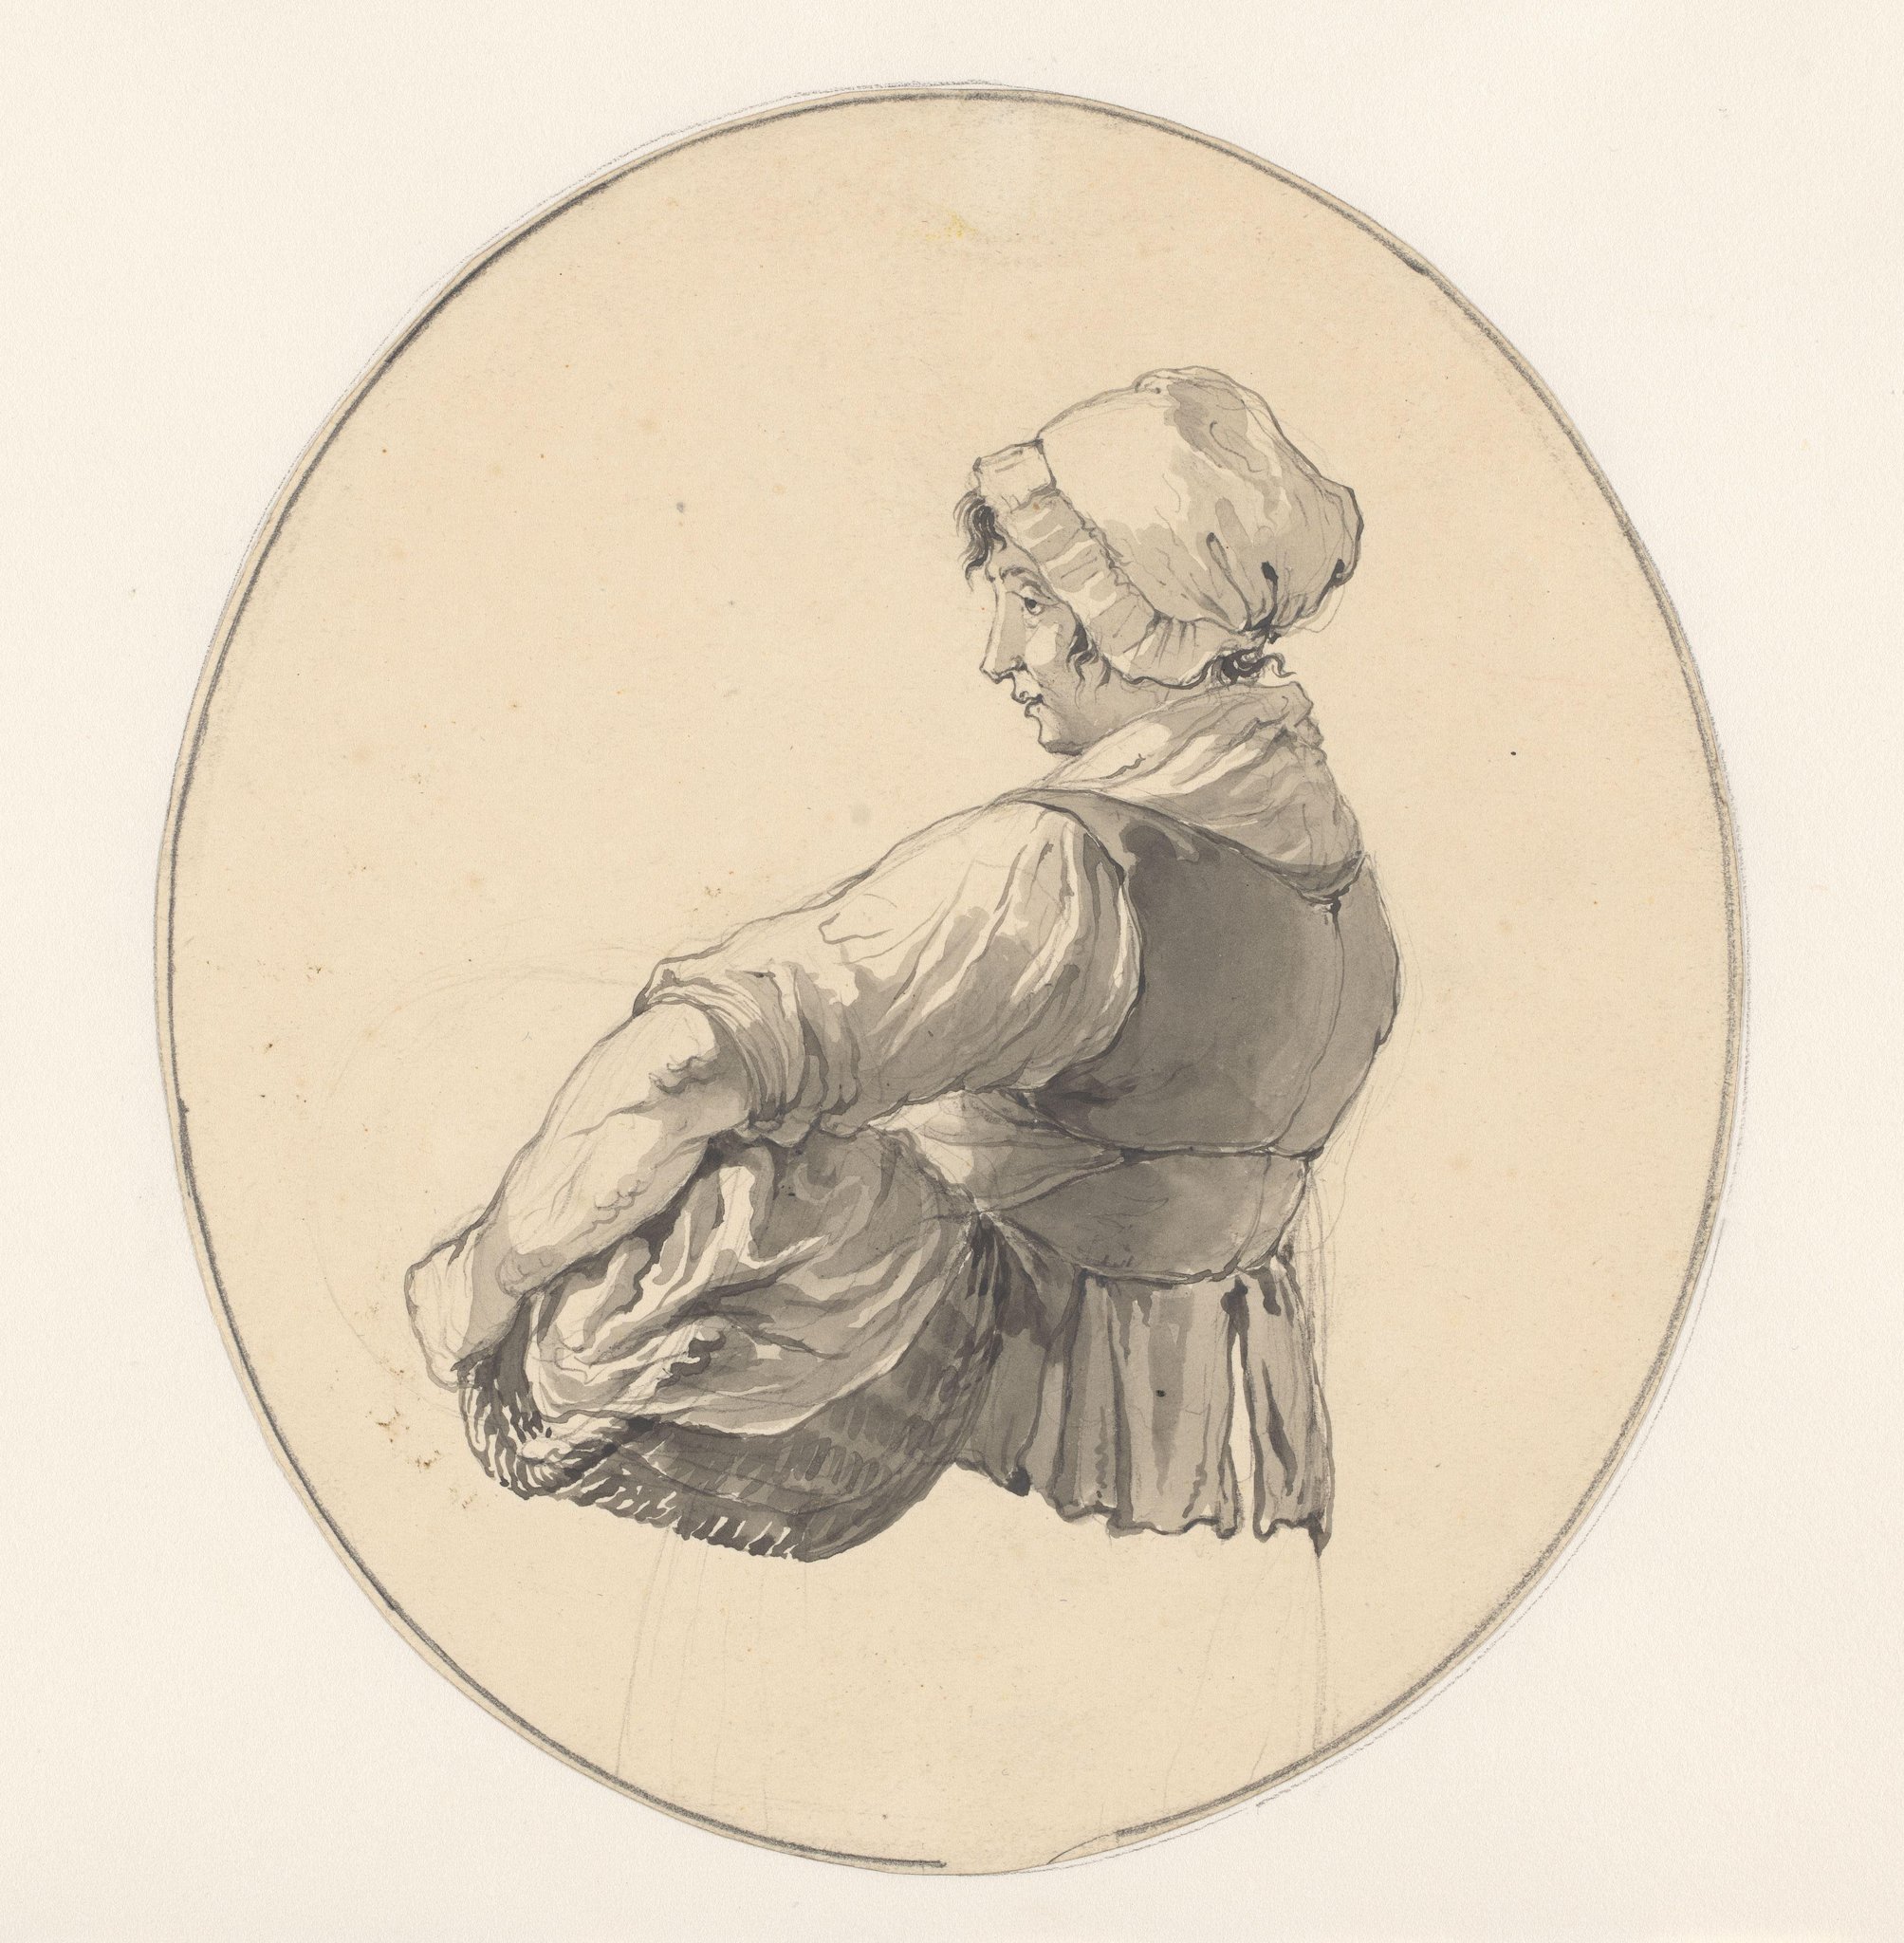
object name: drawing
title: Studie van een vrouw, met een mand onder haar arm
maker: johannes christiaan schotel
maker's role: draughtsman, painter, print maker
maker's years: 1787-1838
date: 1797-1838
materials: ink, paper, pencil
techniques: brush, pen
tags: standing figure, female sex; woman, container made of plant material other than wood: basket